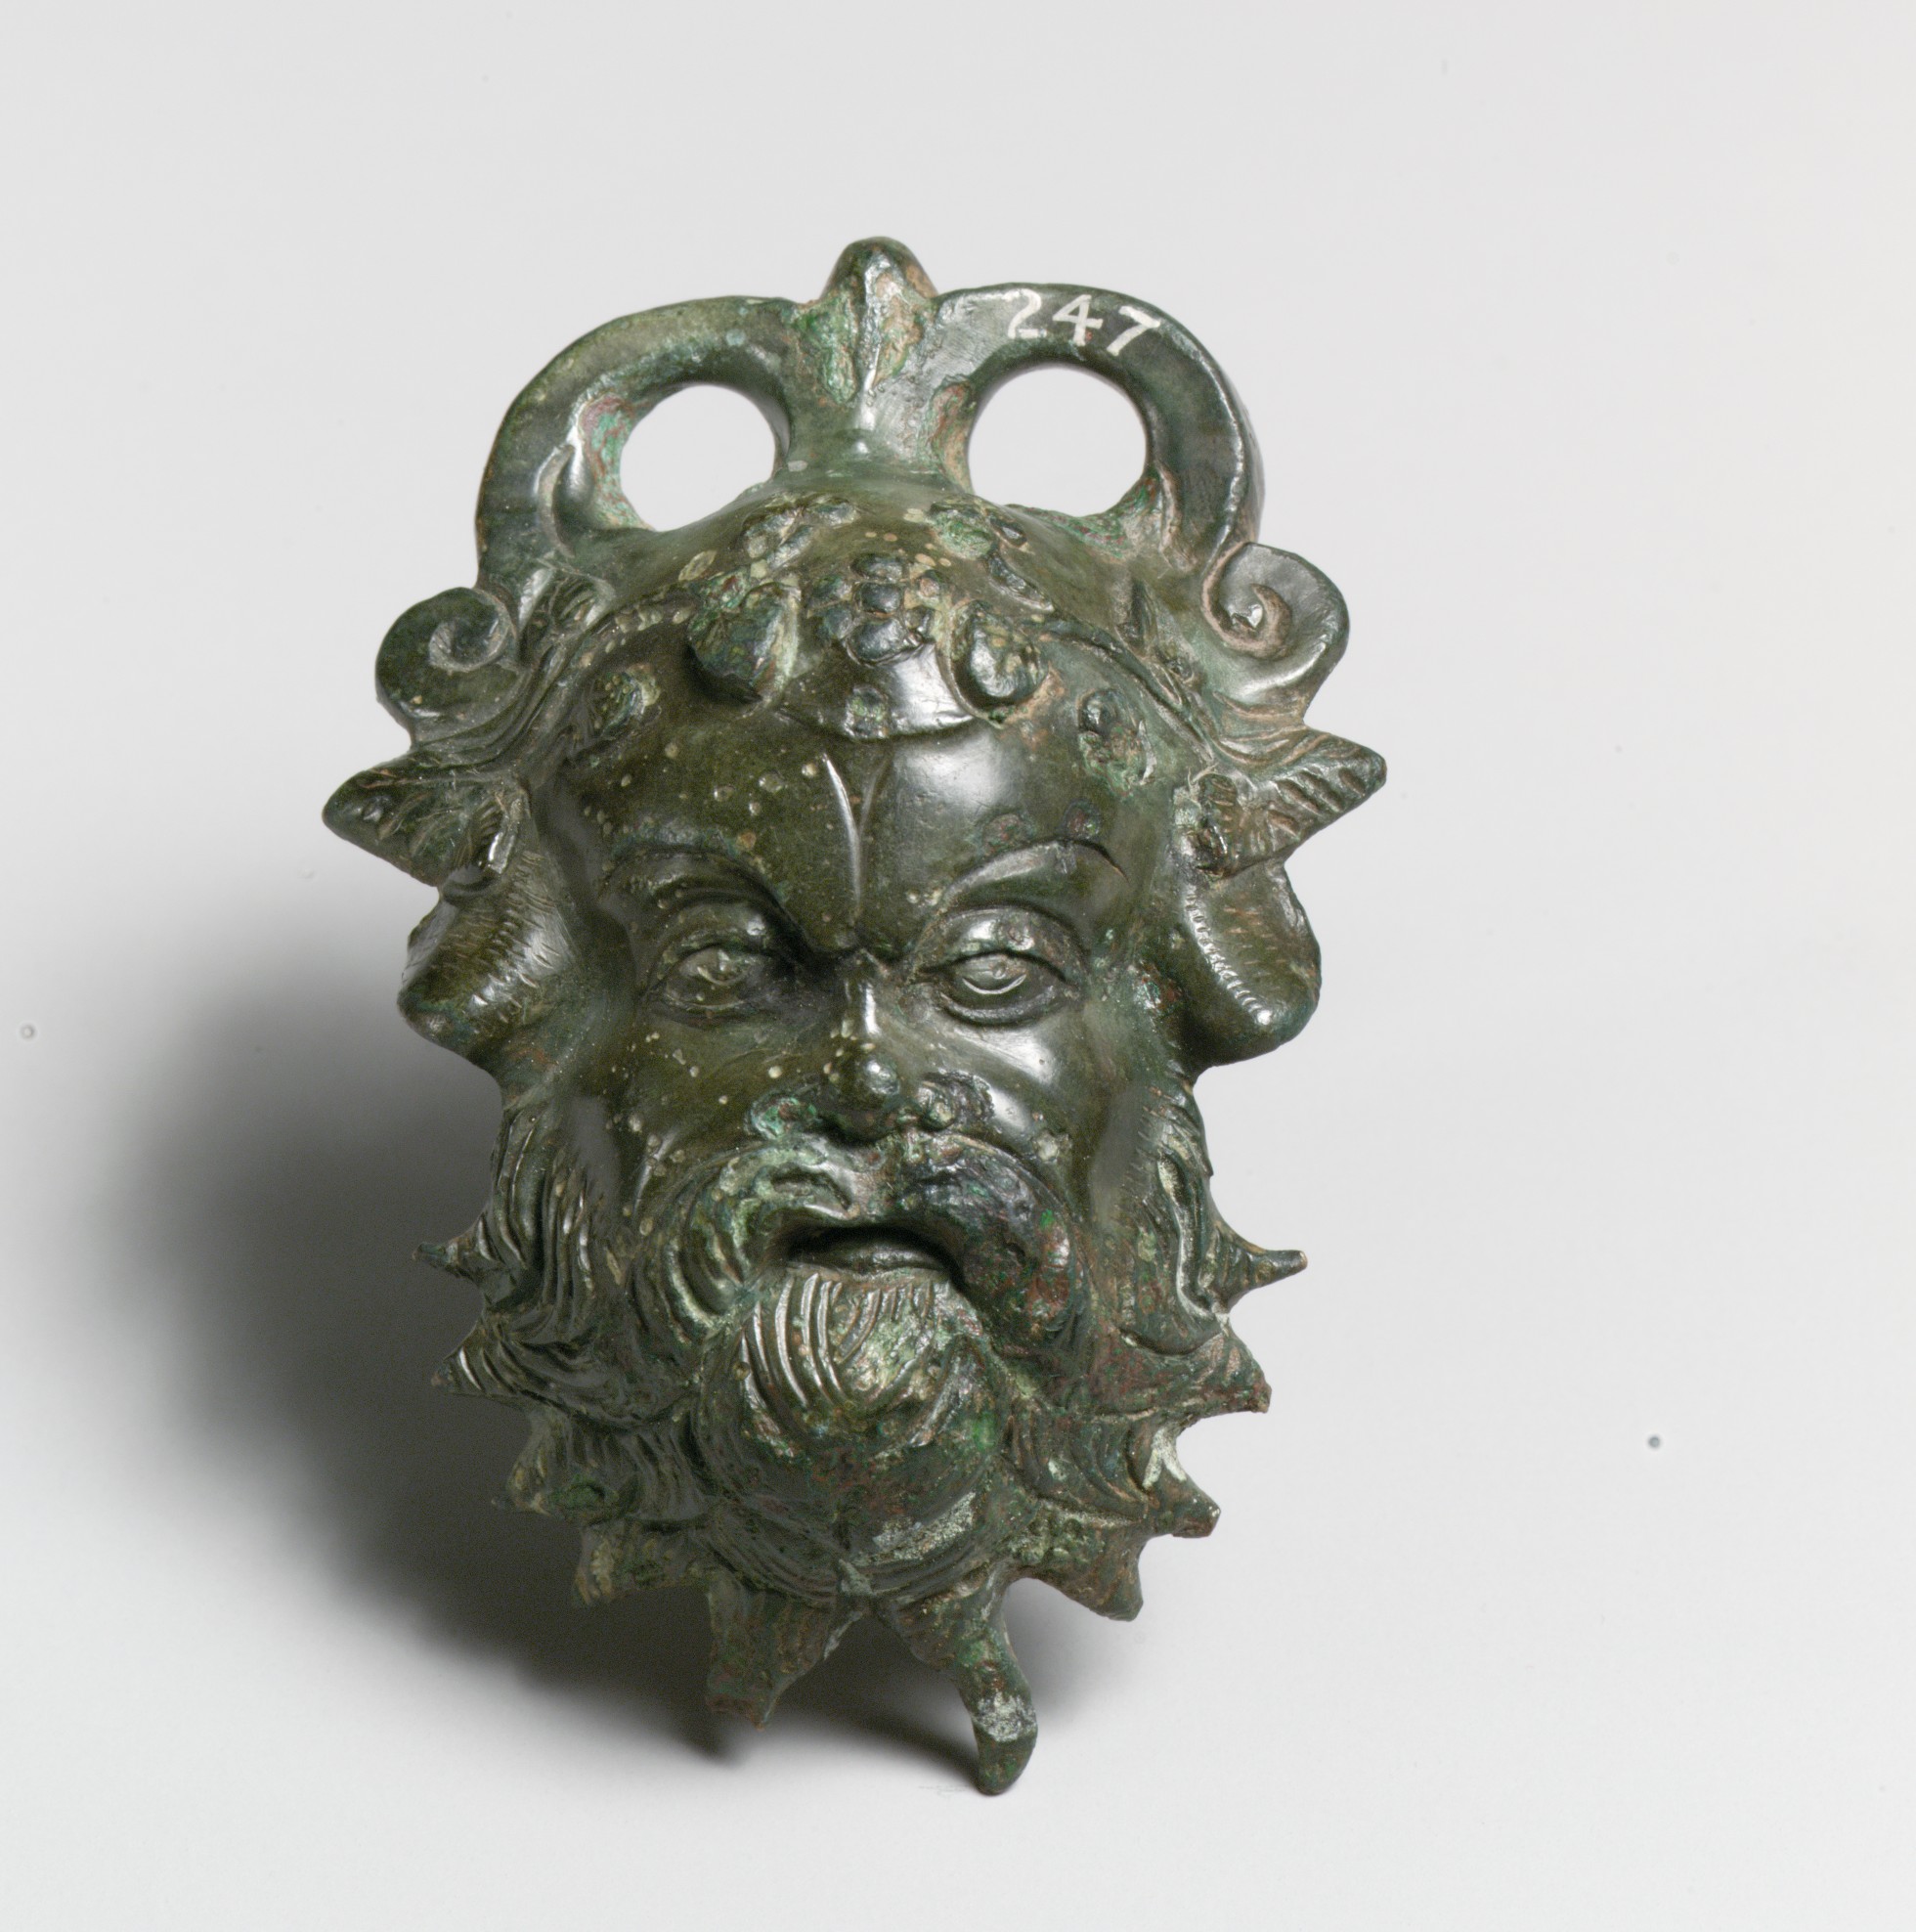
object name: head of silenos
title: Bronze situla (pail) attachment in the form of a Silenos head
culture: greek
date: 400-301 BCE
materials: bronze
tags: heads,silenus